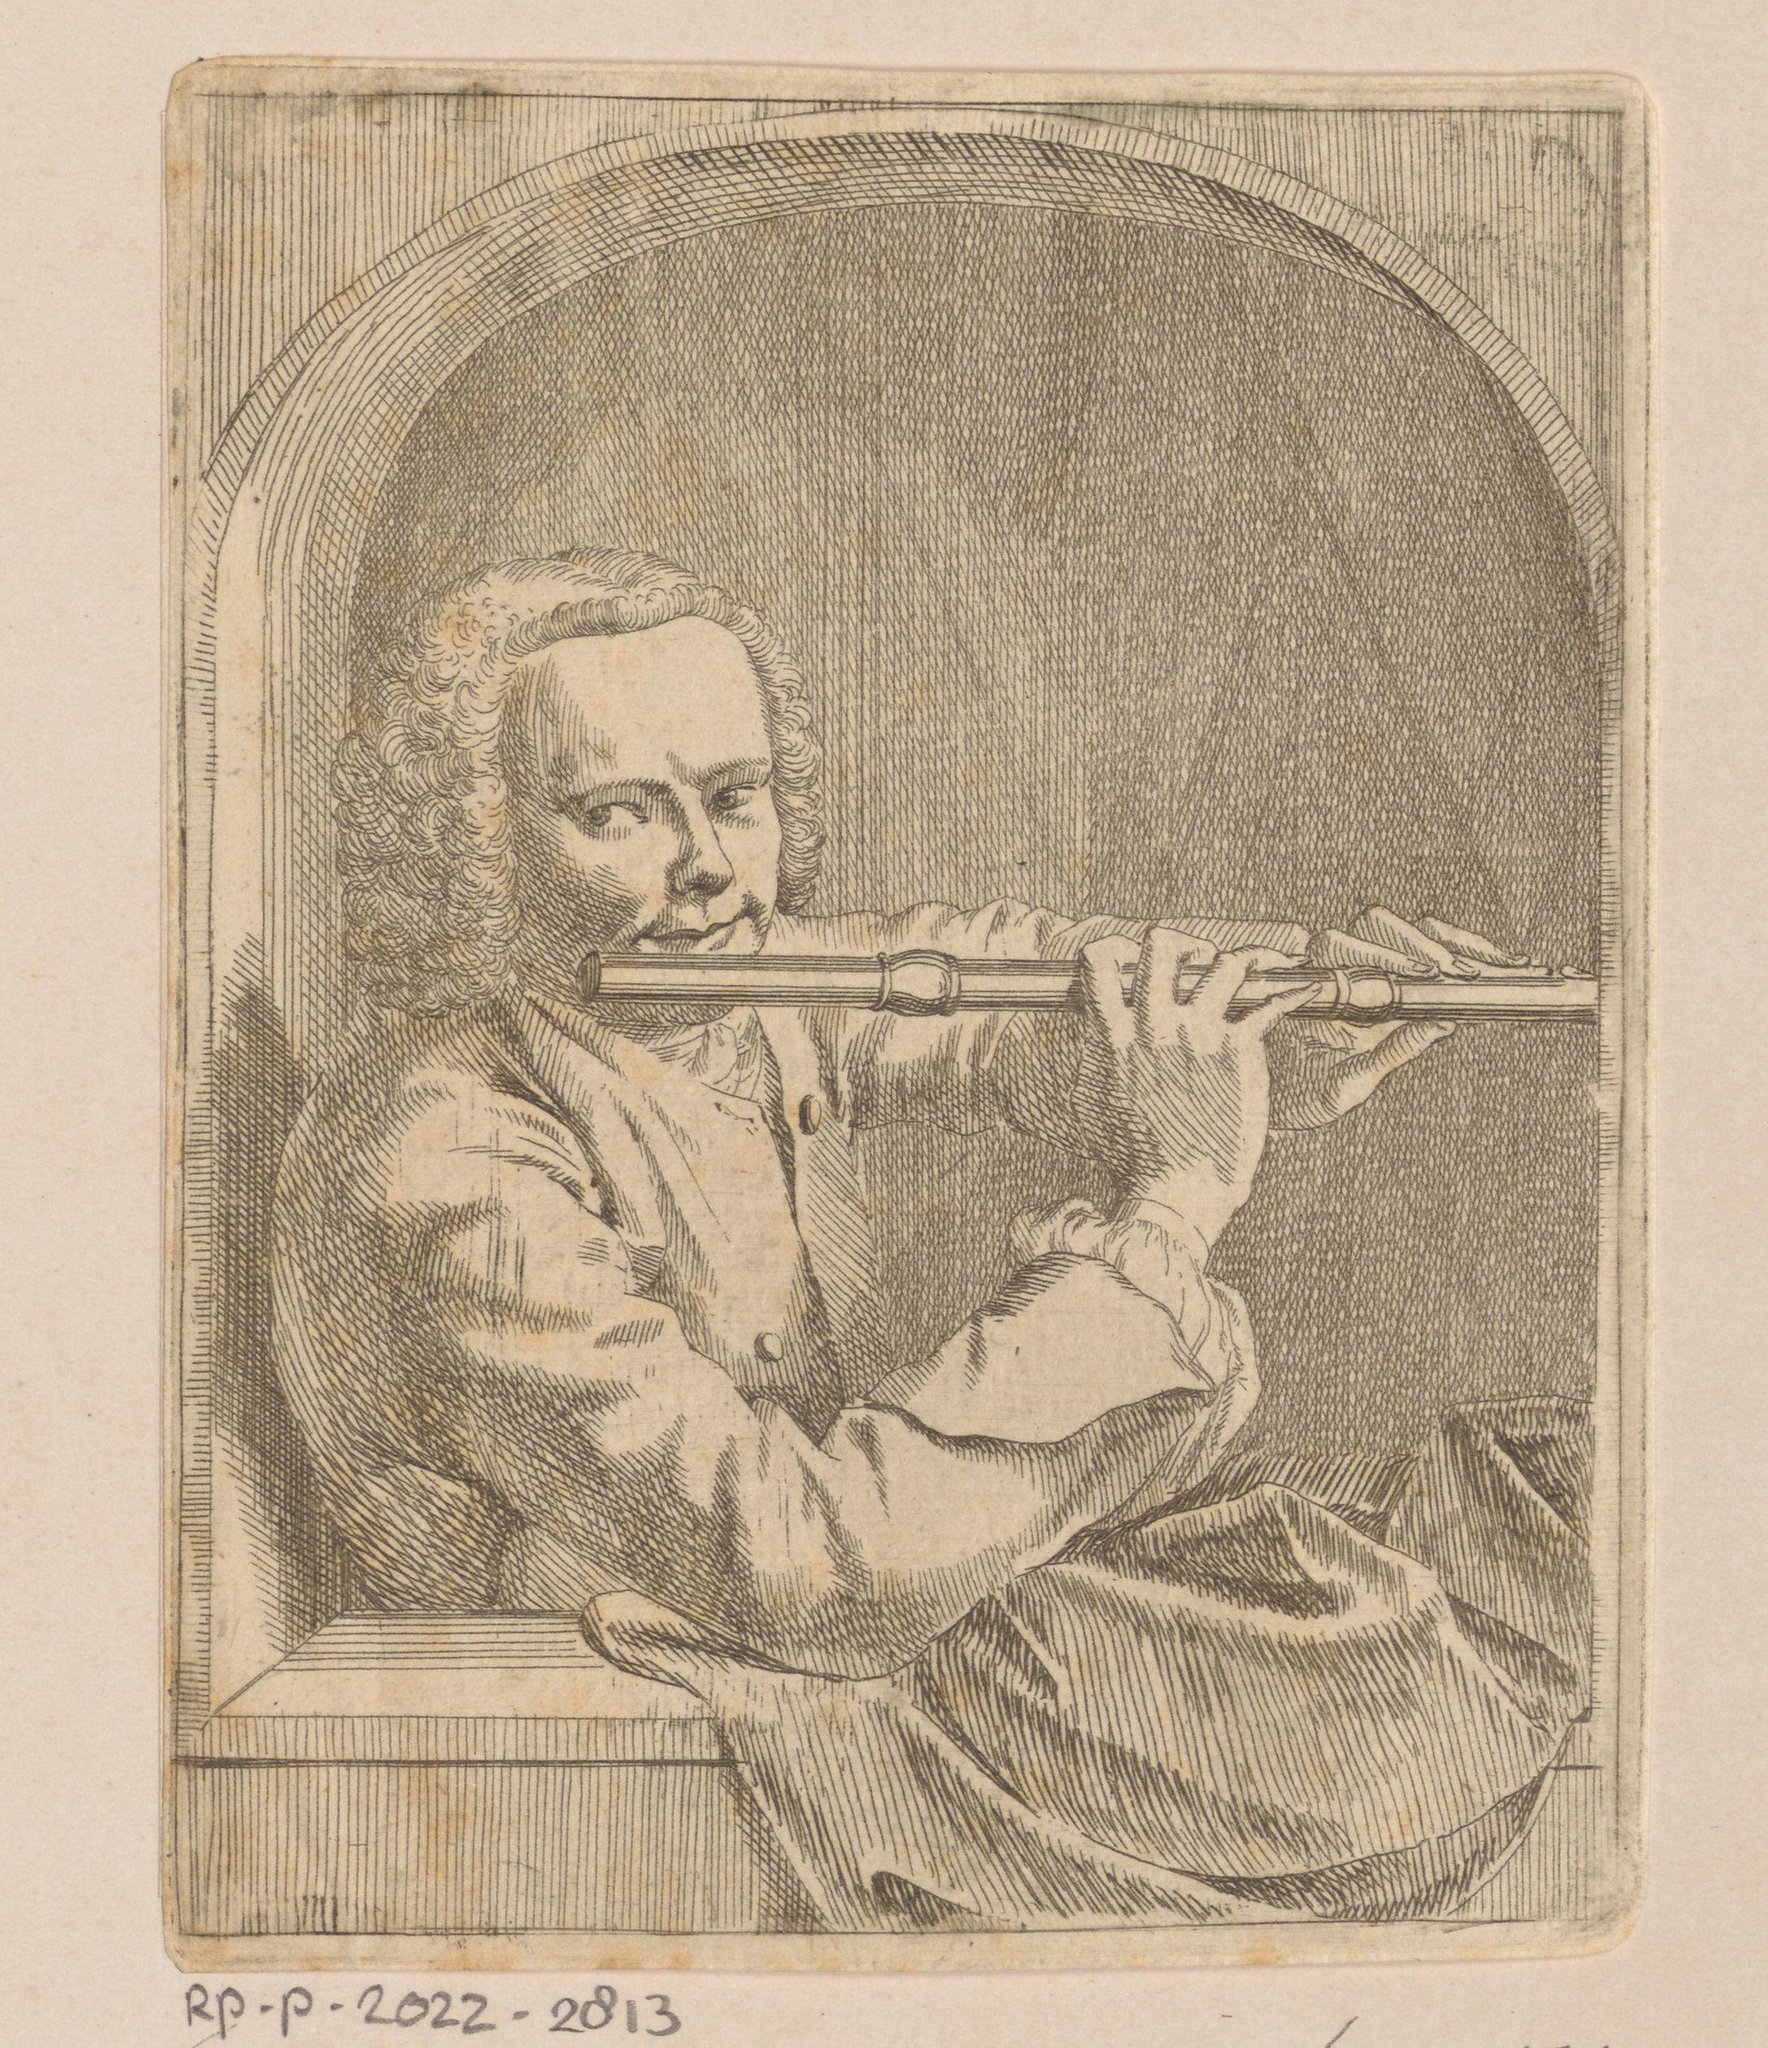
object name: print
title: Portret van Jan Snellen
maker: aert schouman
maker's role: draughtsman, painter, print maker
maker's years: 1710-1792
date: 1736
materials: paper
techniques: etching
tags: rotterdam, draughtsman, jan snellen, historical persons, portrait, self-portrait of artist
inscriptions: collector's mark: Lugt 240